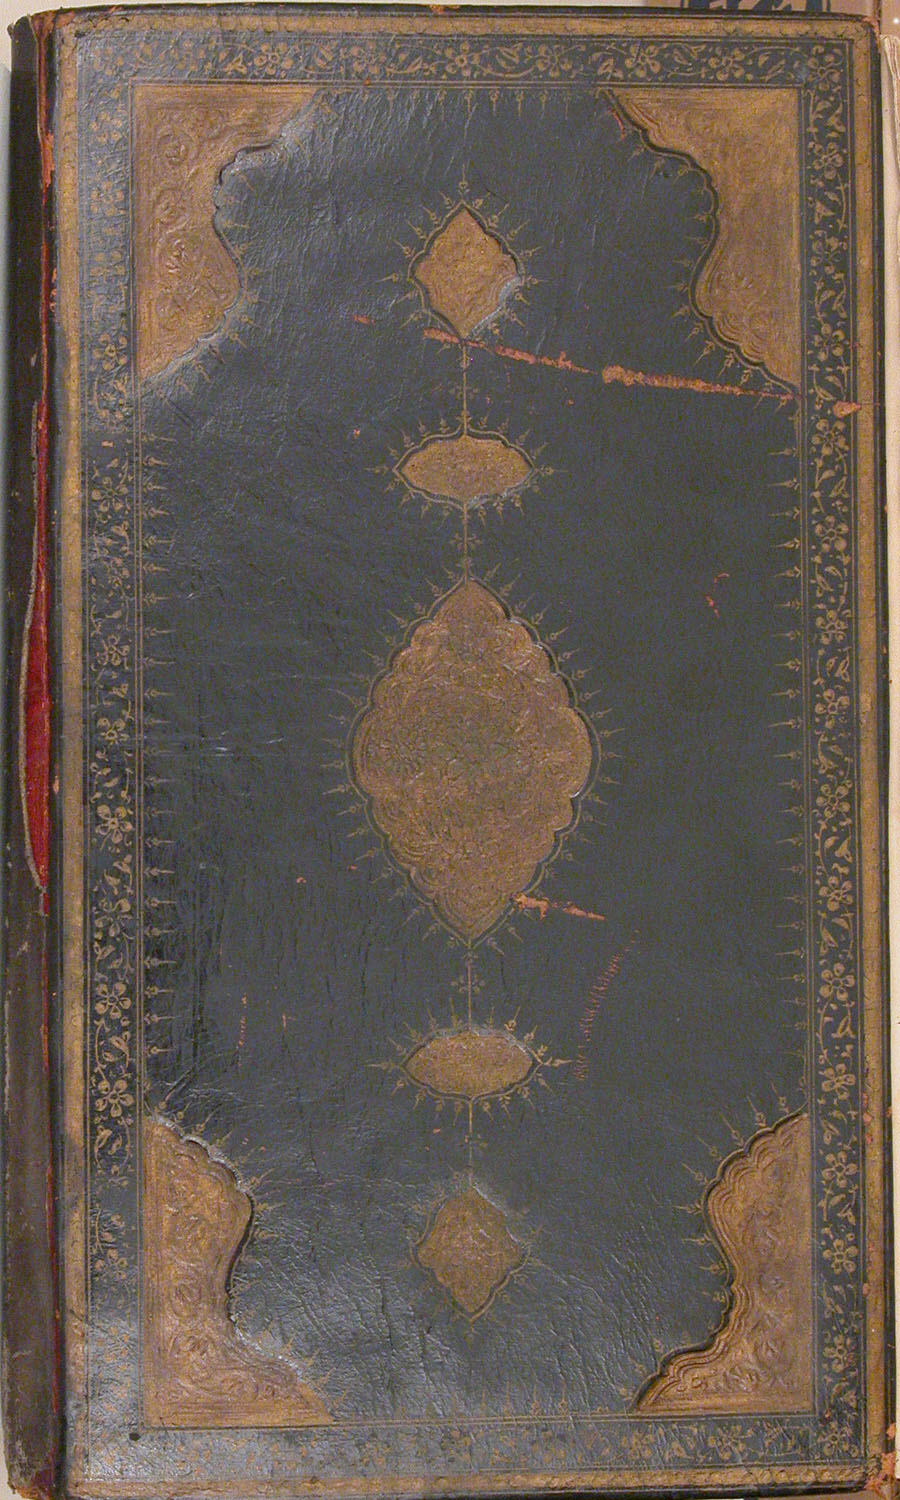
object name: illustrated manuscript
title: Kulliyat (Complete Works) of Sa'di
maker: sa'di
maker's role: author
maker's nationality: iranian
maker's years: 1213-1291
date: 1801-1900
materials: gold, ink, leather, paper, watercolor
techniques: bookbinding, pressed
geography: iran